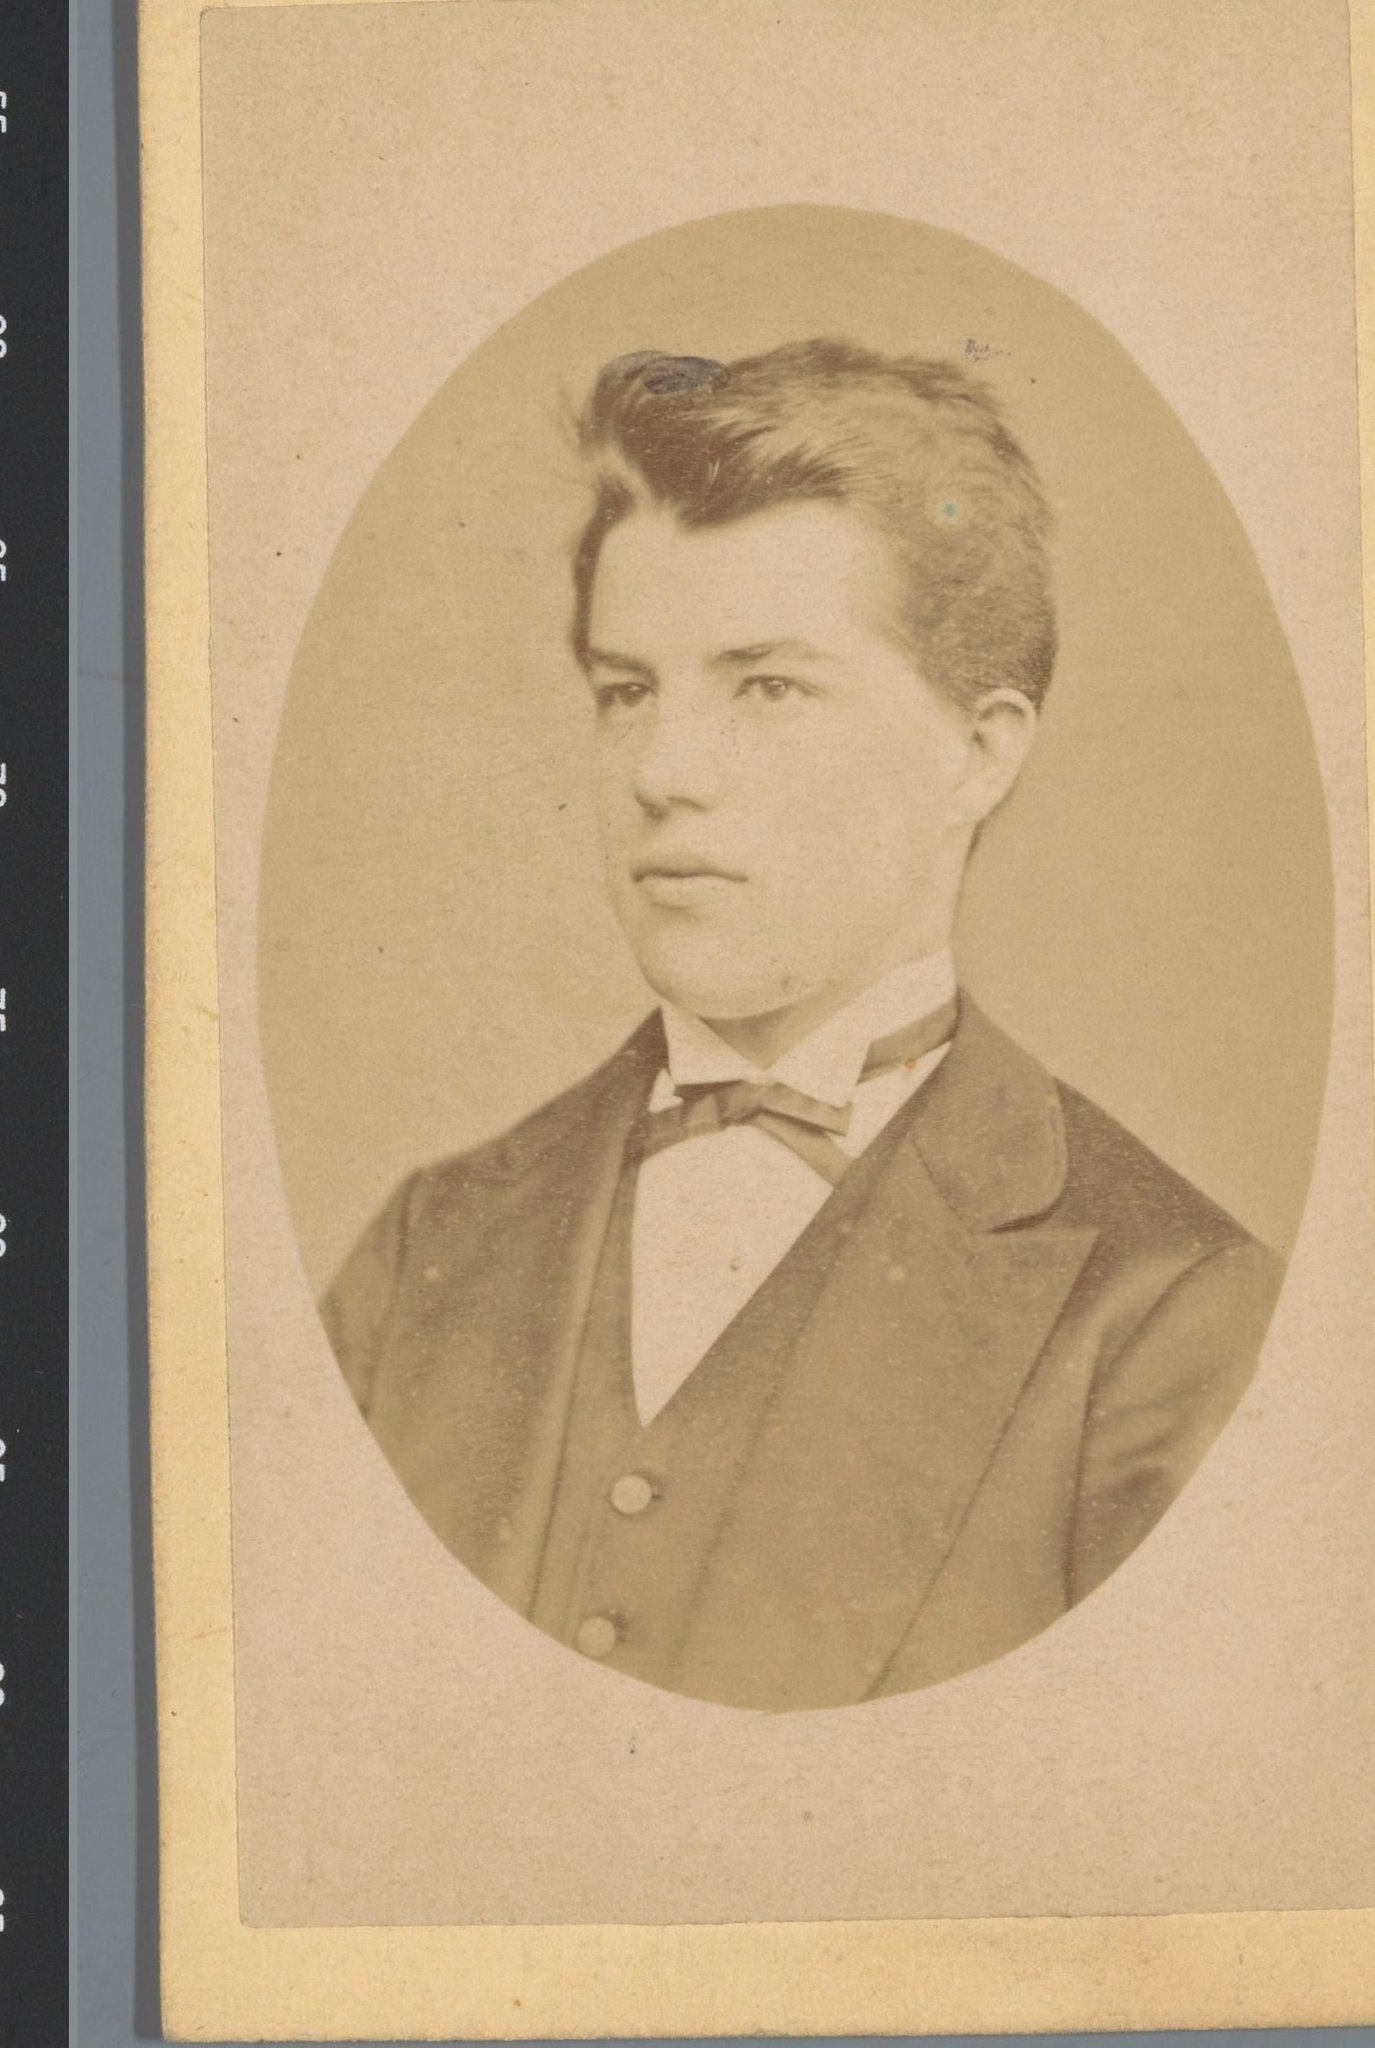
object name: photograph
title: Portret van een onbekende jongeman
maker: george lodewijk mulder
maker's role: fotograaf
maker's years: 1841-1920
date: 1859-1898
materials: cardboard, paper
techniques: albumen print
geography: utrecht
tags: youth, adolescent, anonymous historical person portrayed, utrecht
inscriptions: inscription: ‘Photogr. Atelier/ G.L. Mulder/ van Wijckskade H.326./ Utrecht.’